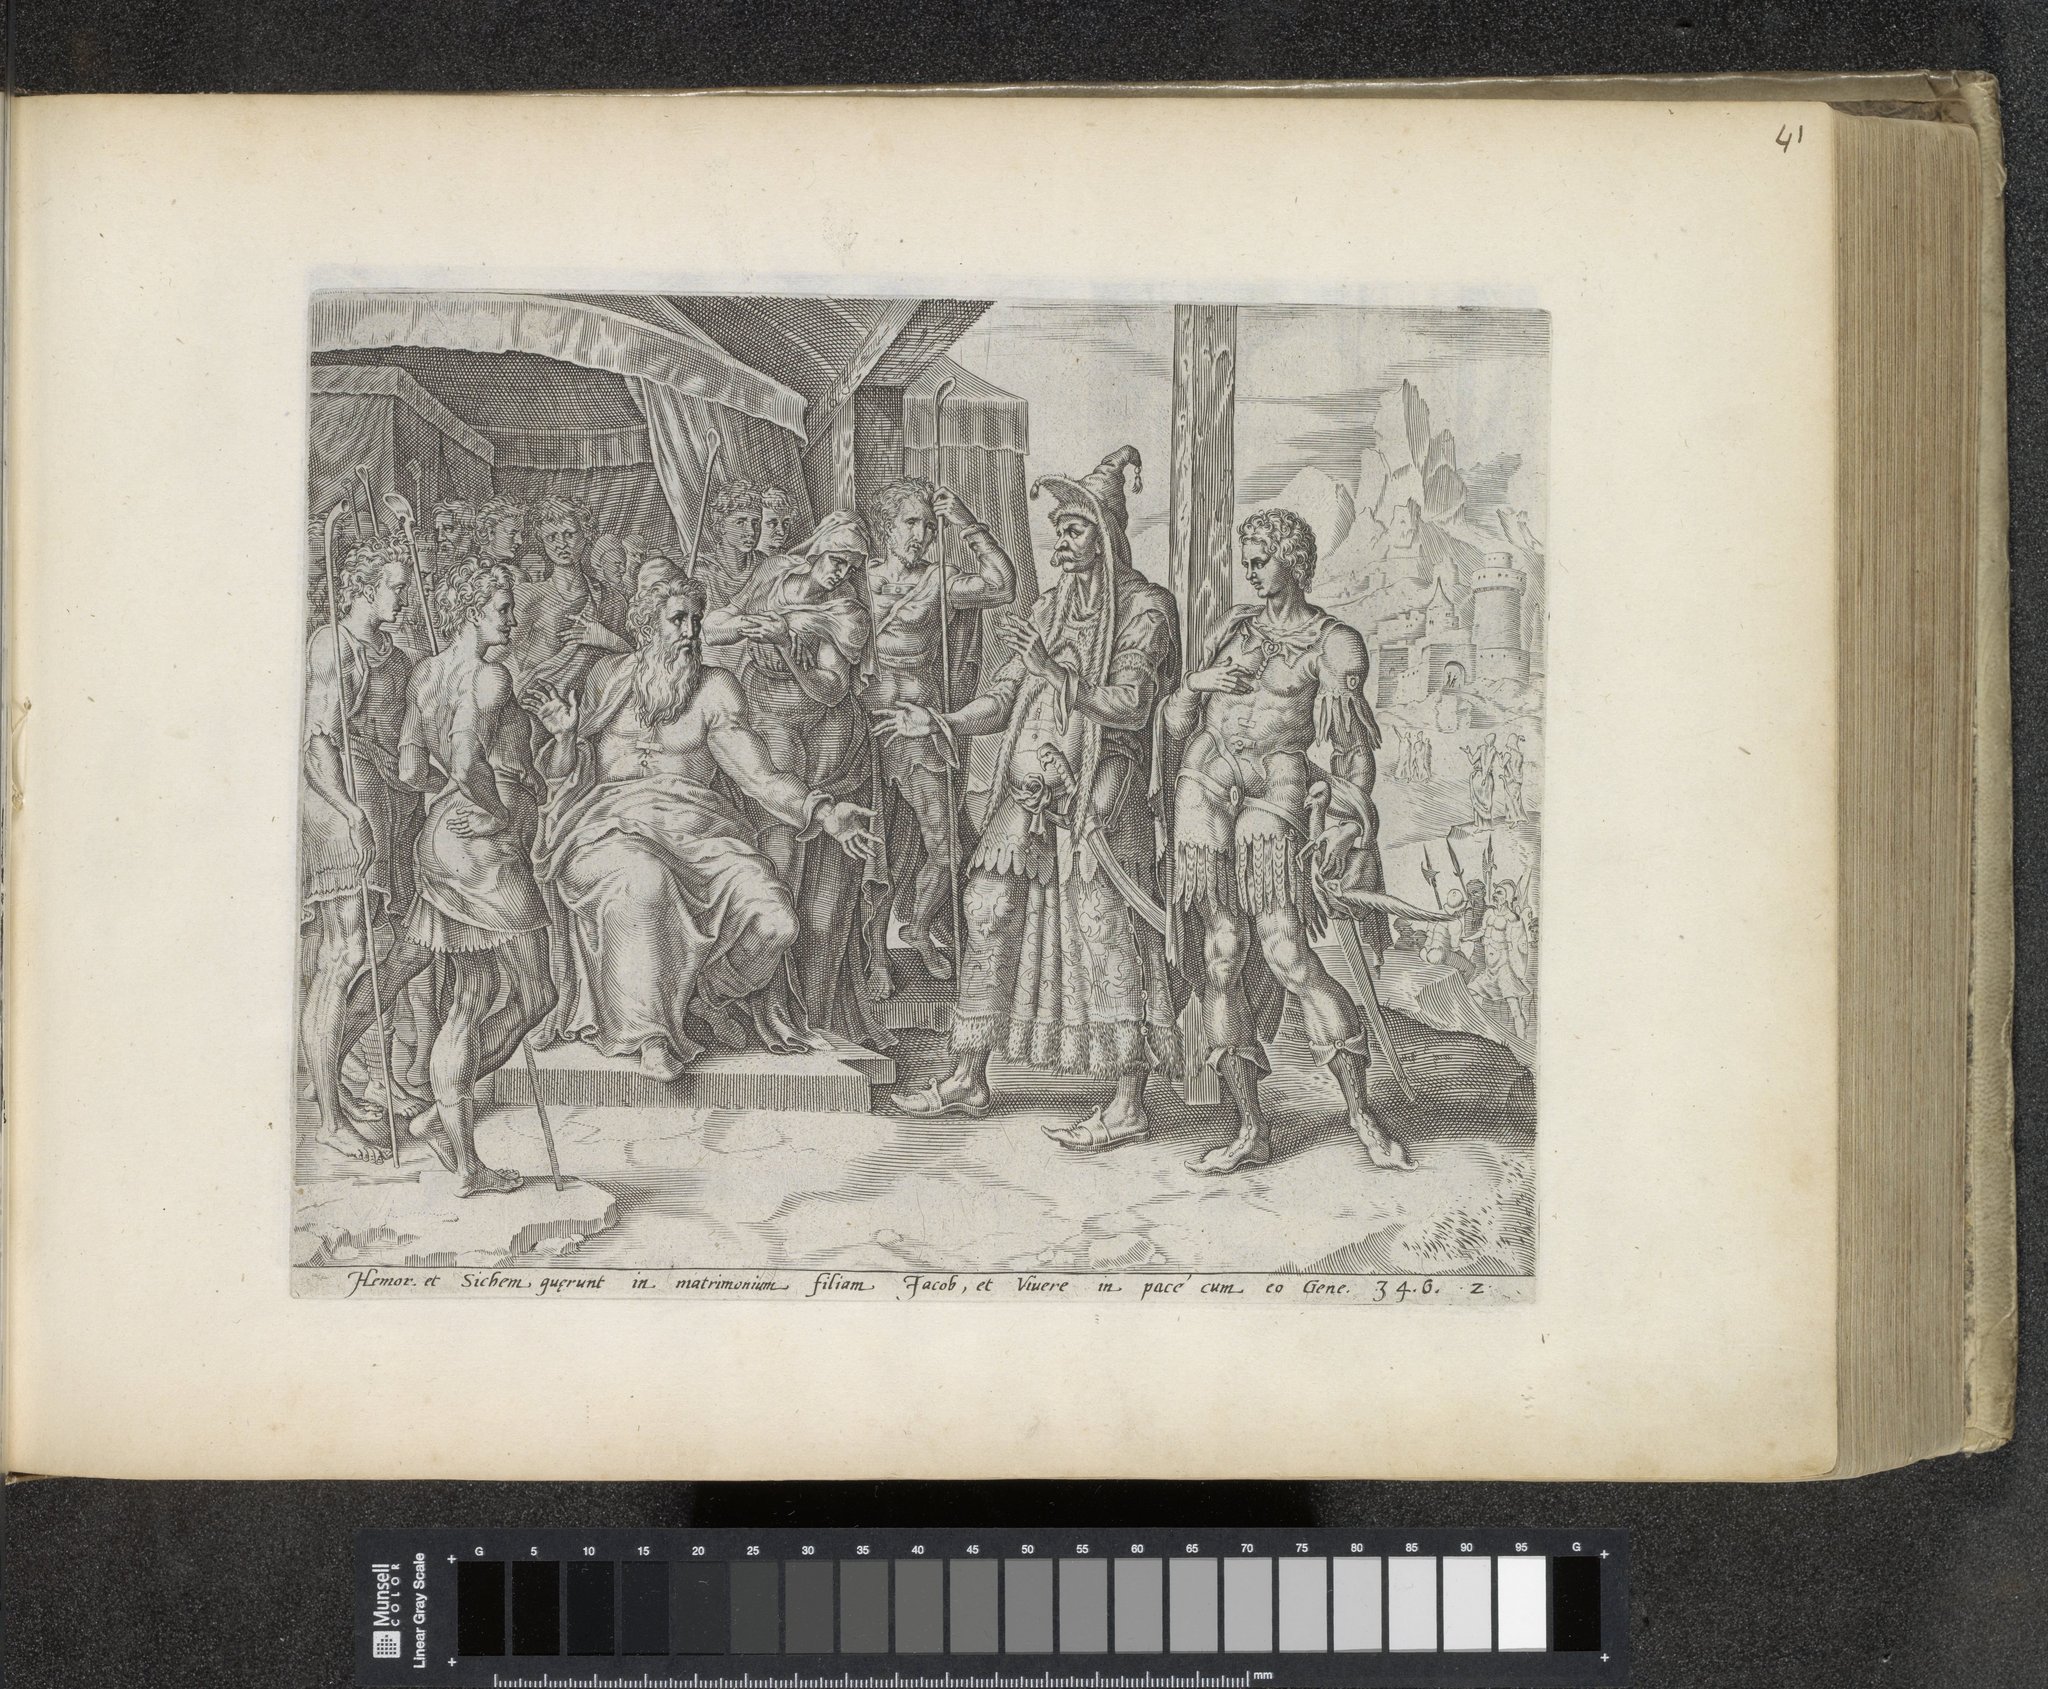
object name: album leaf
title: Geschiedenis van Dina en Sichem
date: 1585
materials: paper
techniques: engraving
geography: amsterdam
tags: hamor and shechem come to jacob, whose sons have just come in from the fields, to ask for dinah in marriage; the sons agree on condition that the shechemites will be circumcised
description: Sichem en zijn vader Chamor komen bij Jakob en vragen hem om zijn dochter Dina uit te huwelijken aan Sichem. Jakob zit in zijn tent omringd door zijn vrouw en twaalf zonen. Jakobs zonen stellen de voorwaarde dat Sichem en zijn volk besneden moeten worden, omdat ze hun vrouwen alleen aan besneden mannen willen uithuwelijken. Onderaan in de marge een verwijzing in het Latijn naar de Bijbeltekst in Gen. 34:6. Deze prent maakt deel uit van een album.